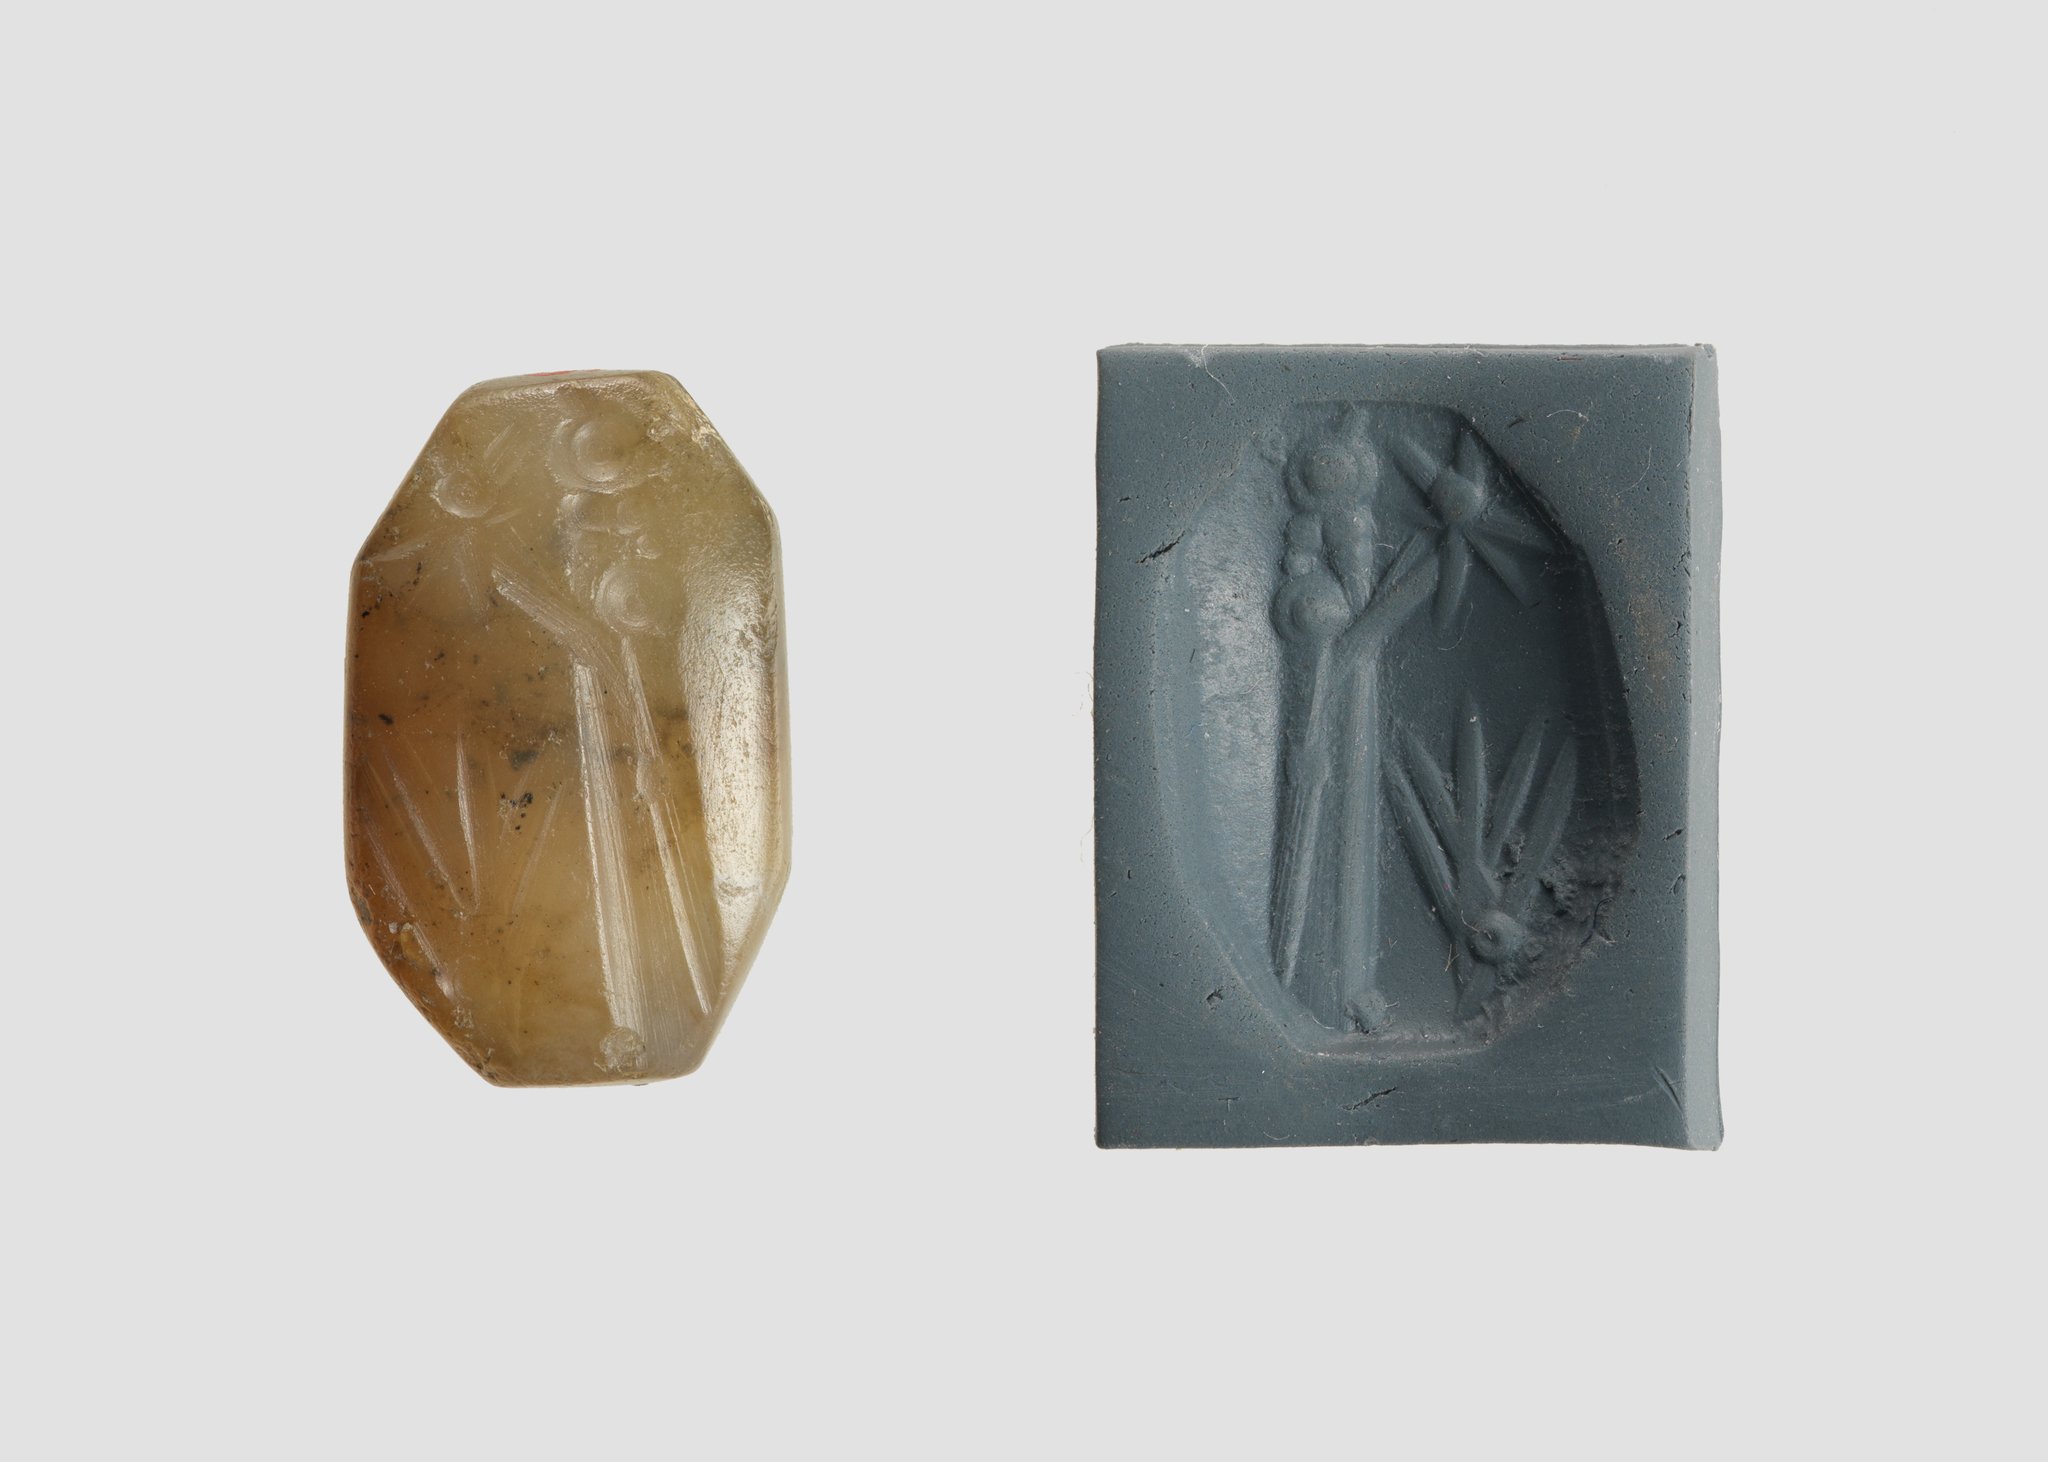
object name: stamp seal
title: Stamp seal (octagonal pyramid) with cultic scene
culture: assyro-babylonian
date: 700-501 BCE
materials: stone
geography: mesopotamia